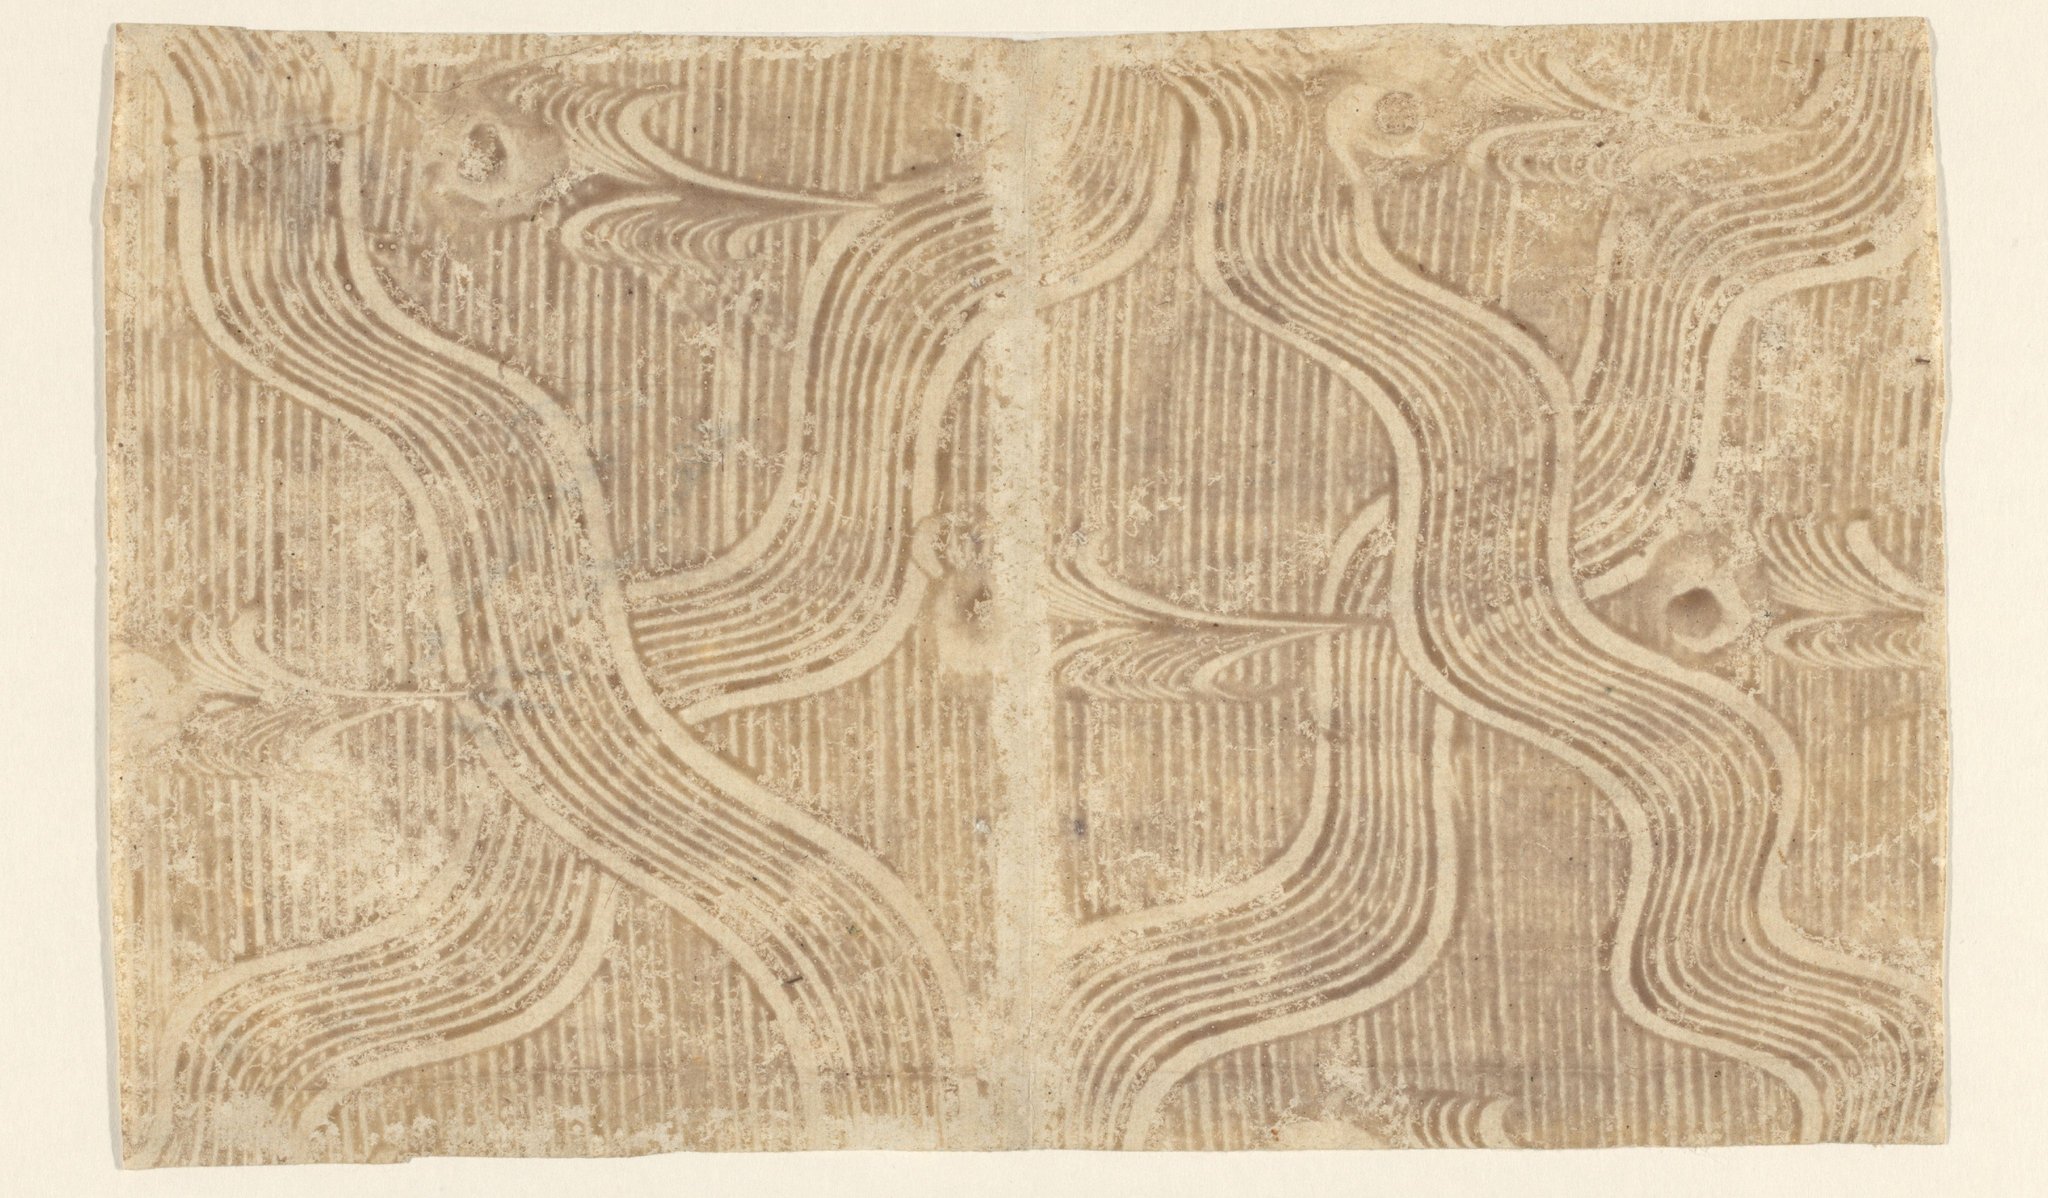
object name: wrapper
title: Decorated Paper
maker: Anonymous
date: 1780-1820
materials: paper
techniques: scoring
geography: netherlands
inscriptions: annotation: ‘Publicatie Deventer 1798’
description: For centuries, paper decorated with printed or handmade patterns was used to cover books and to apply to furniture. F.G. Waller donated some 750 examples to the museum. Recently, the collection was expanded with sheets collected by the print historian Jan van der Waals (1947-2009), including some highly eccentric and exuberant examples.